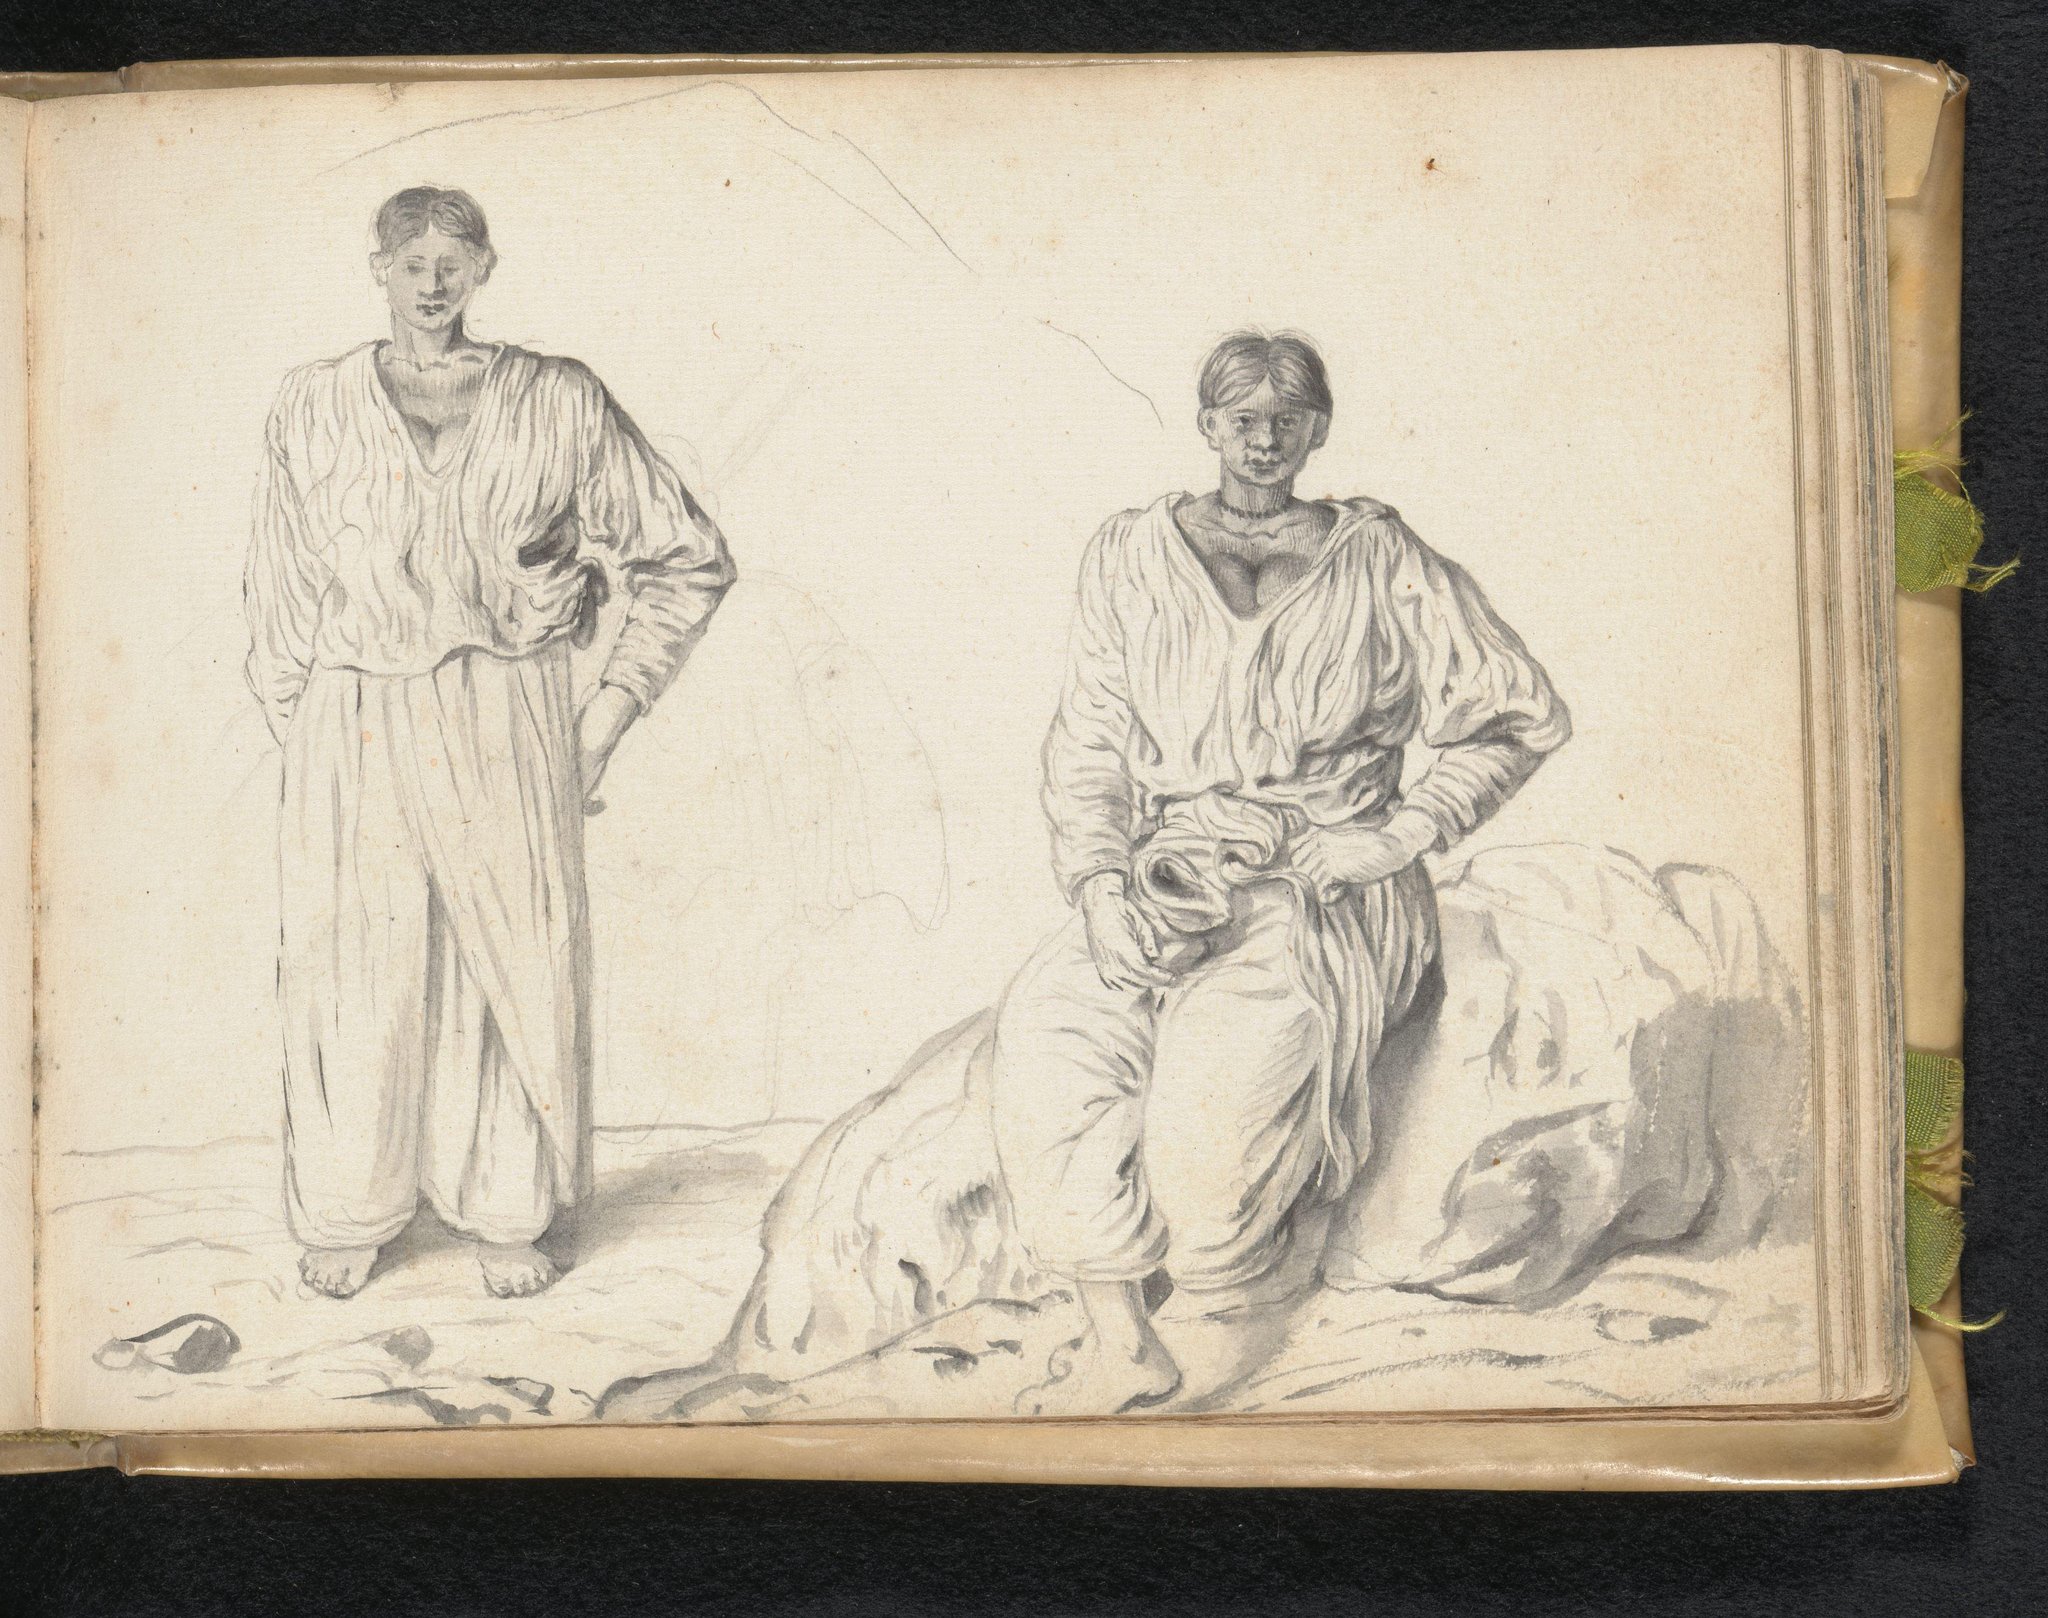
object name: sketchbook leaf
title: Two women at a roadside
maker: esaias boursse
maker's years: 1631-1672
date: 1662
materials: ink, paper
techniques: brush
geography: sri lanka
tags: asiatic races and peoples (with name), eurasion, half-caste, skirt (with name), clothing for the upper part of the body (with name), styles of hairdress (with name) - ~women, sri lanka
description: Naast elkaar een staande en een zittende vrouw. De vrouw rechts zit op een rotsblok langs de kant van de weg. Beide vrouwen zijn gekleed in een lange wikkelrok (redda). Daarboven dragen ze een wijde Portugese bloes met V-hals en lange mouwen (hatte). Bij beiden is het haar in het midden gescheiden en strak naar achter vastgestoken in een wrong (condé). De zittende vrouw lijkt met haar rechterhand een open zakje vast te houden op haar schoot. Om haar hals draagt ze een strak kralensnoertje. Beide vrouwen zijn Euraziatisch of Singalees. Midden op het blad naast de staande vrouw een vage schets van een staande figuur met wikkelrok. Blad 77 uit een schetsboek met 117 bladen.